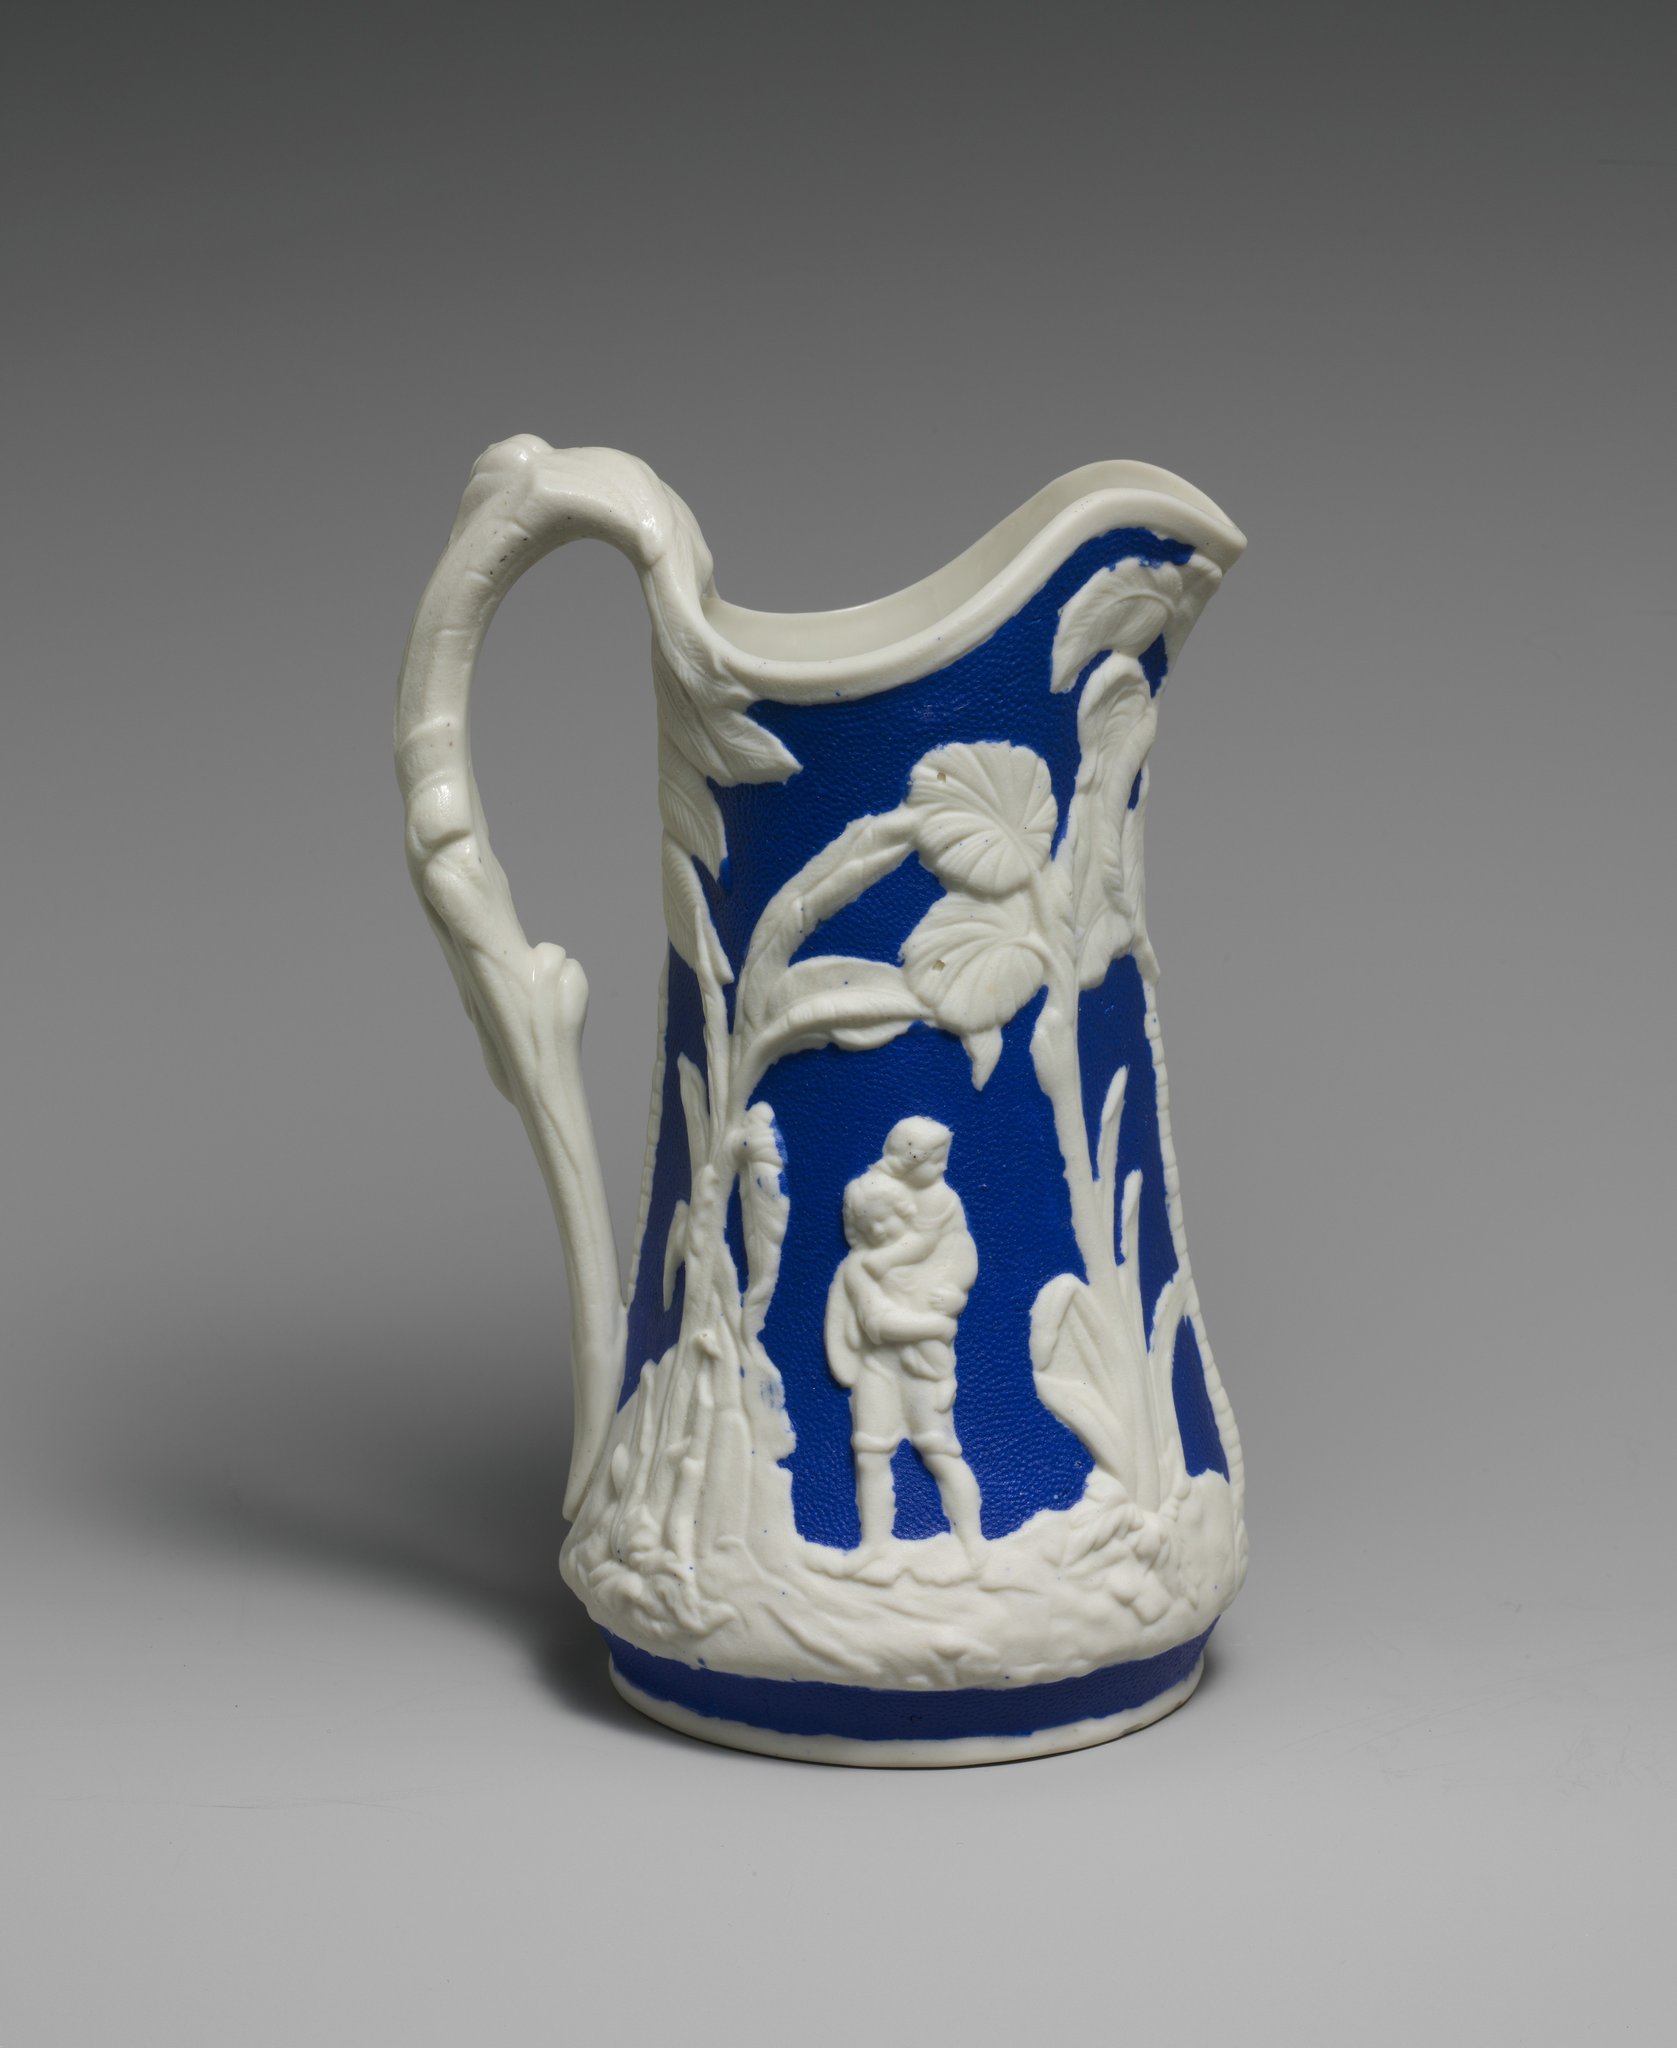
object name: pitcher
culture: american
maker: united states pottery company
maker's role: maker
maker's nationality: american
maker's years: 1852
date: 1852-1858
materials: porcelain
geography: united states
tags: human figures